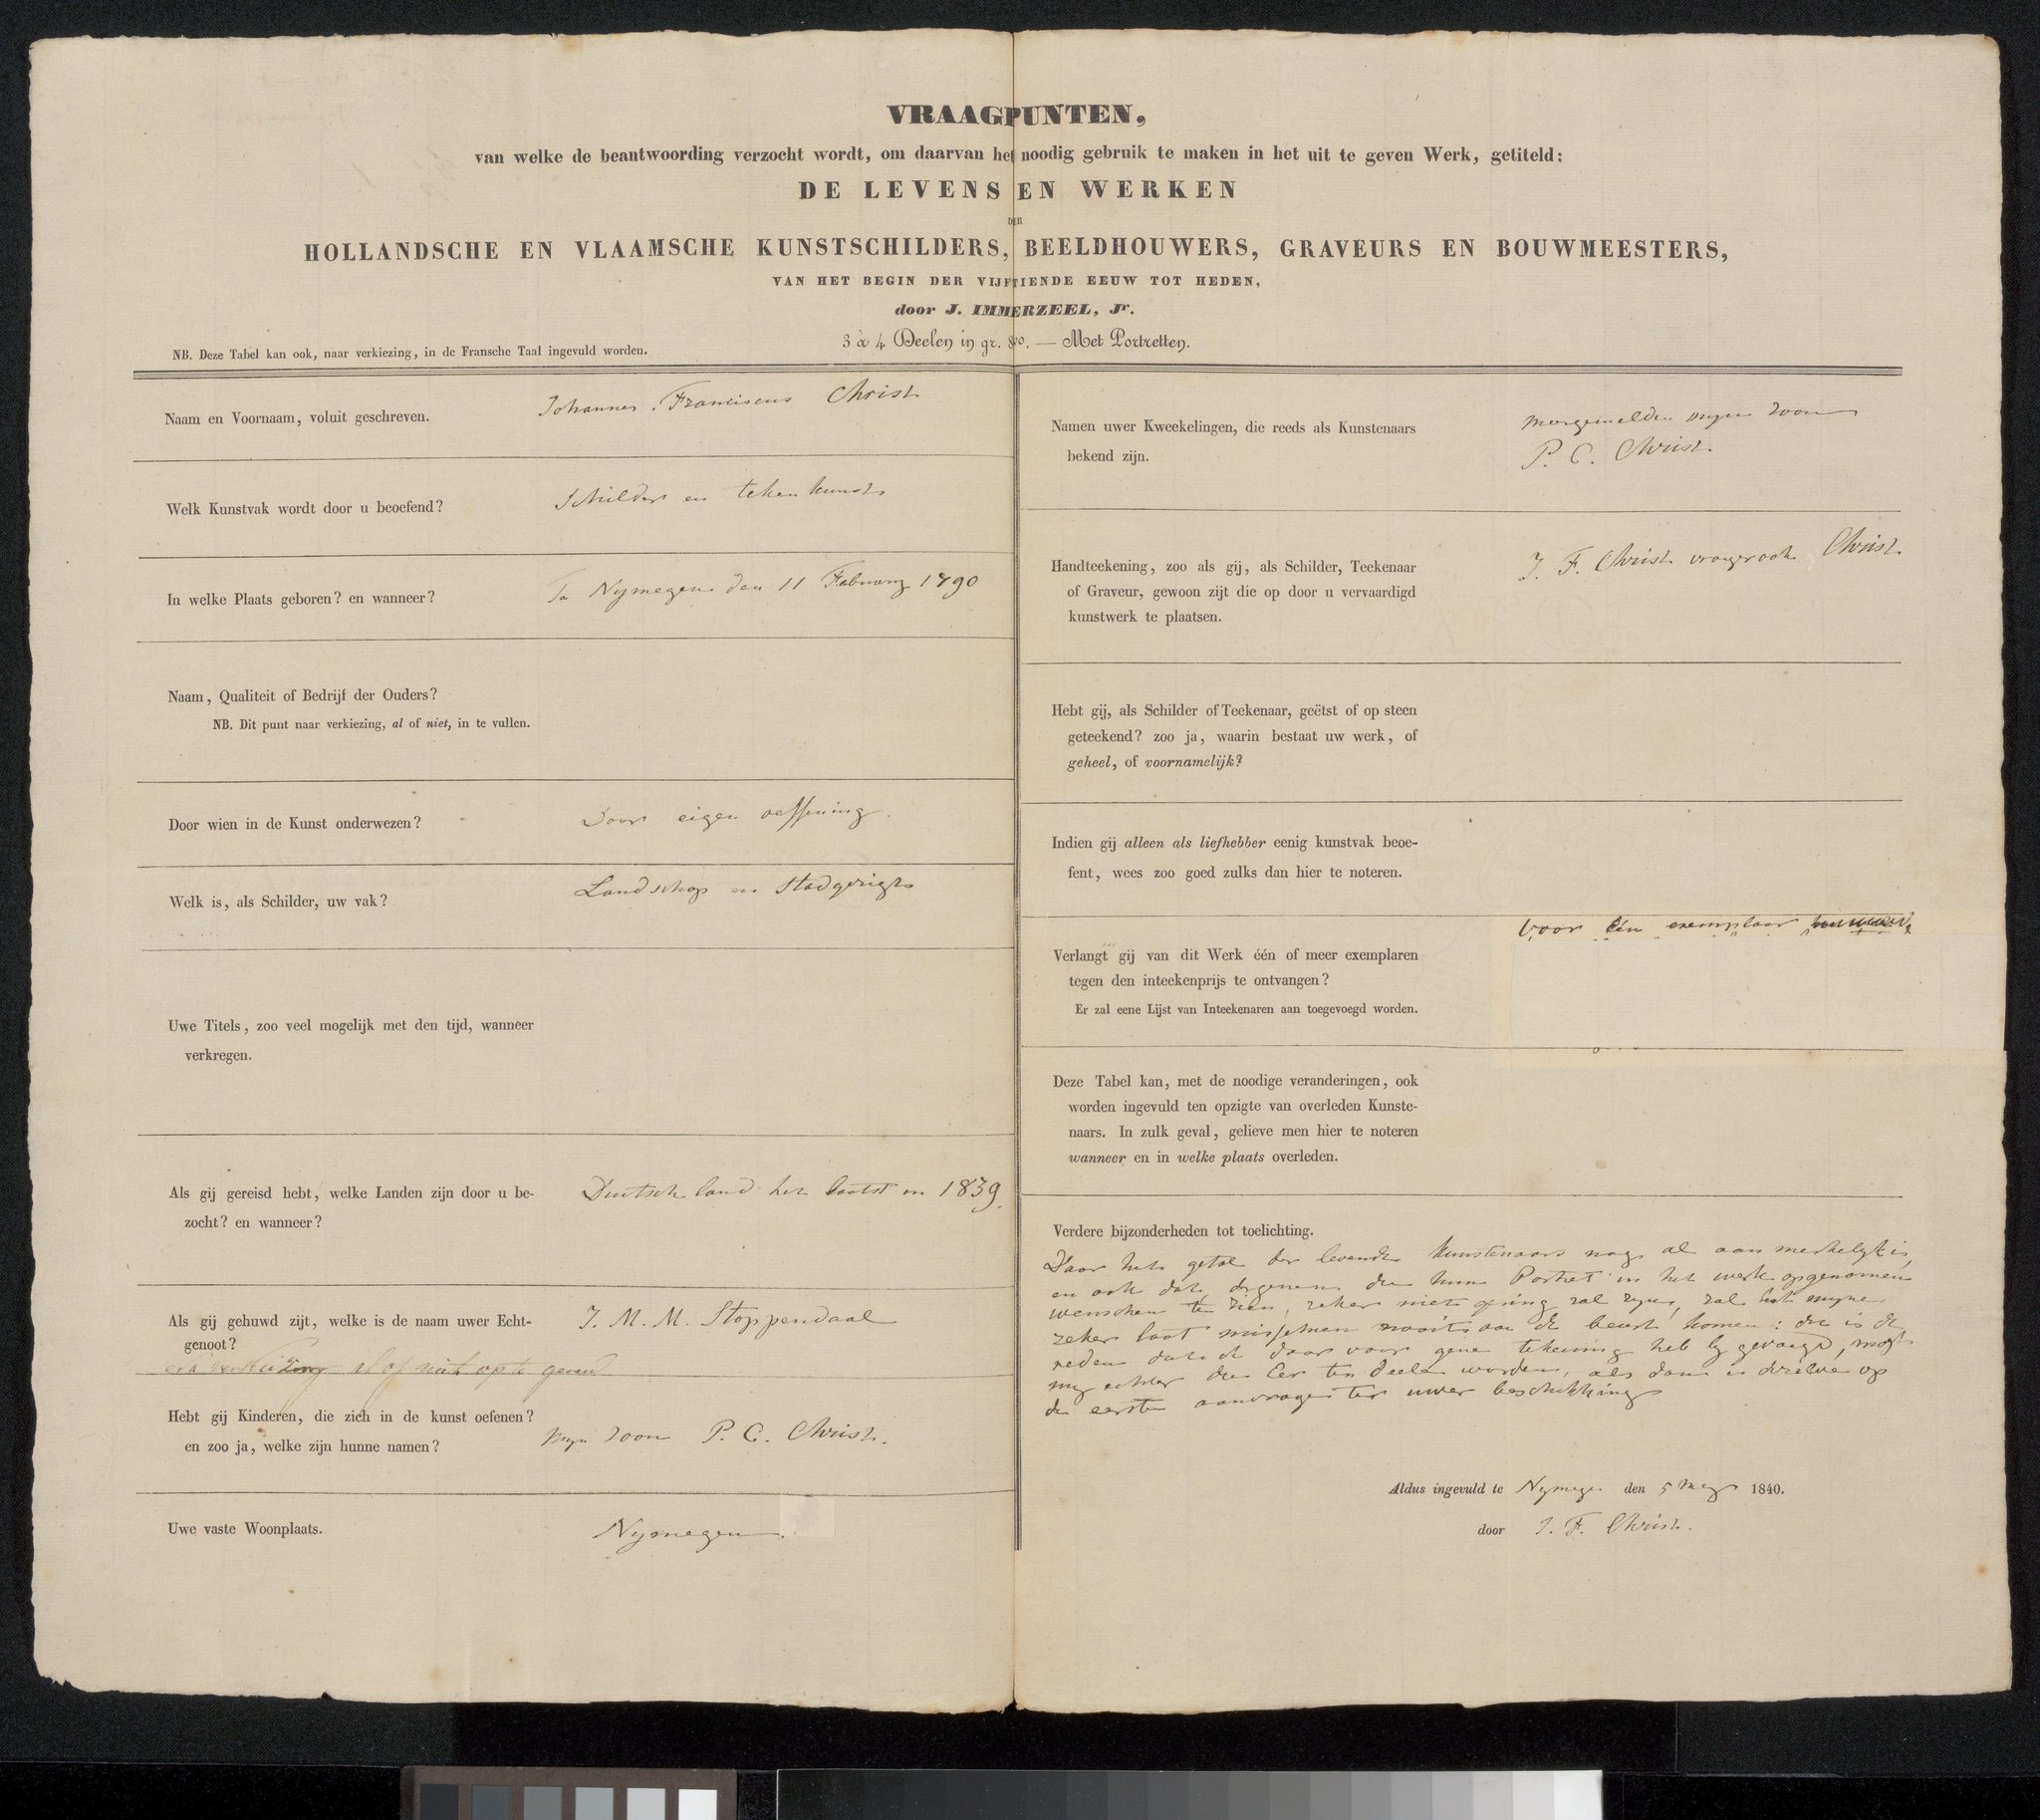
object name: manuscript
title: Enquêteformulier ingevuld door Johannes Franciscus Christ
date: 1840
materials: ink, paper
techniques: pen, printing, writing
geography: nijmegen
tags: nijmegen, draughtsman, johannes franciscus christ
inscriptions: inscription: ‘Vraagpunten,/ van welke de beantwoording verzocht wordt, om daarvan het noodig gebruik te maken in het uit te geven Werk, getiteld: De levens en werken/ der Hollandsche en Vlaamsche kunstschilders, beeldhouwers,/ graveurs en bouwmeesters, van het begin der vijftiende eeuw tot heden/ door J. Immerzeel, Jr.’, watermark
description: Opgenomen in: Immerzeel, J. Jr., De levens en werken der Hollandsche en Vlaamsche kunstschilders, beeldhouwers, graveurs en bouwmeesters, van het begin der vijftiende eeuw tot heden, Amsterdam: J.C. van Kesteren, 1842-1843.